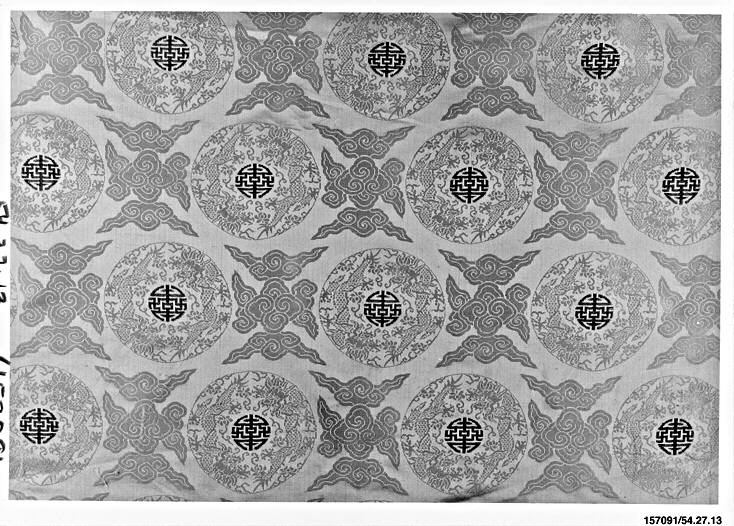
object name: length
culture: chinese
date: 1867-1900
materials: metal thread, silk